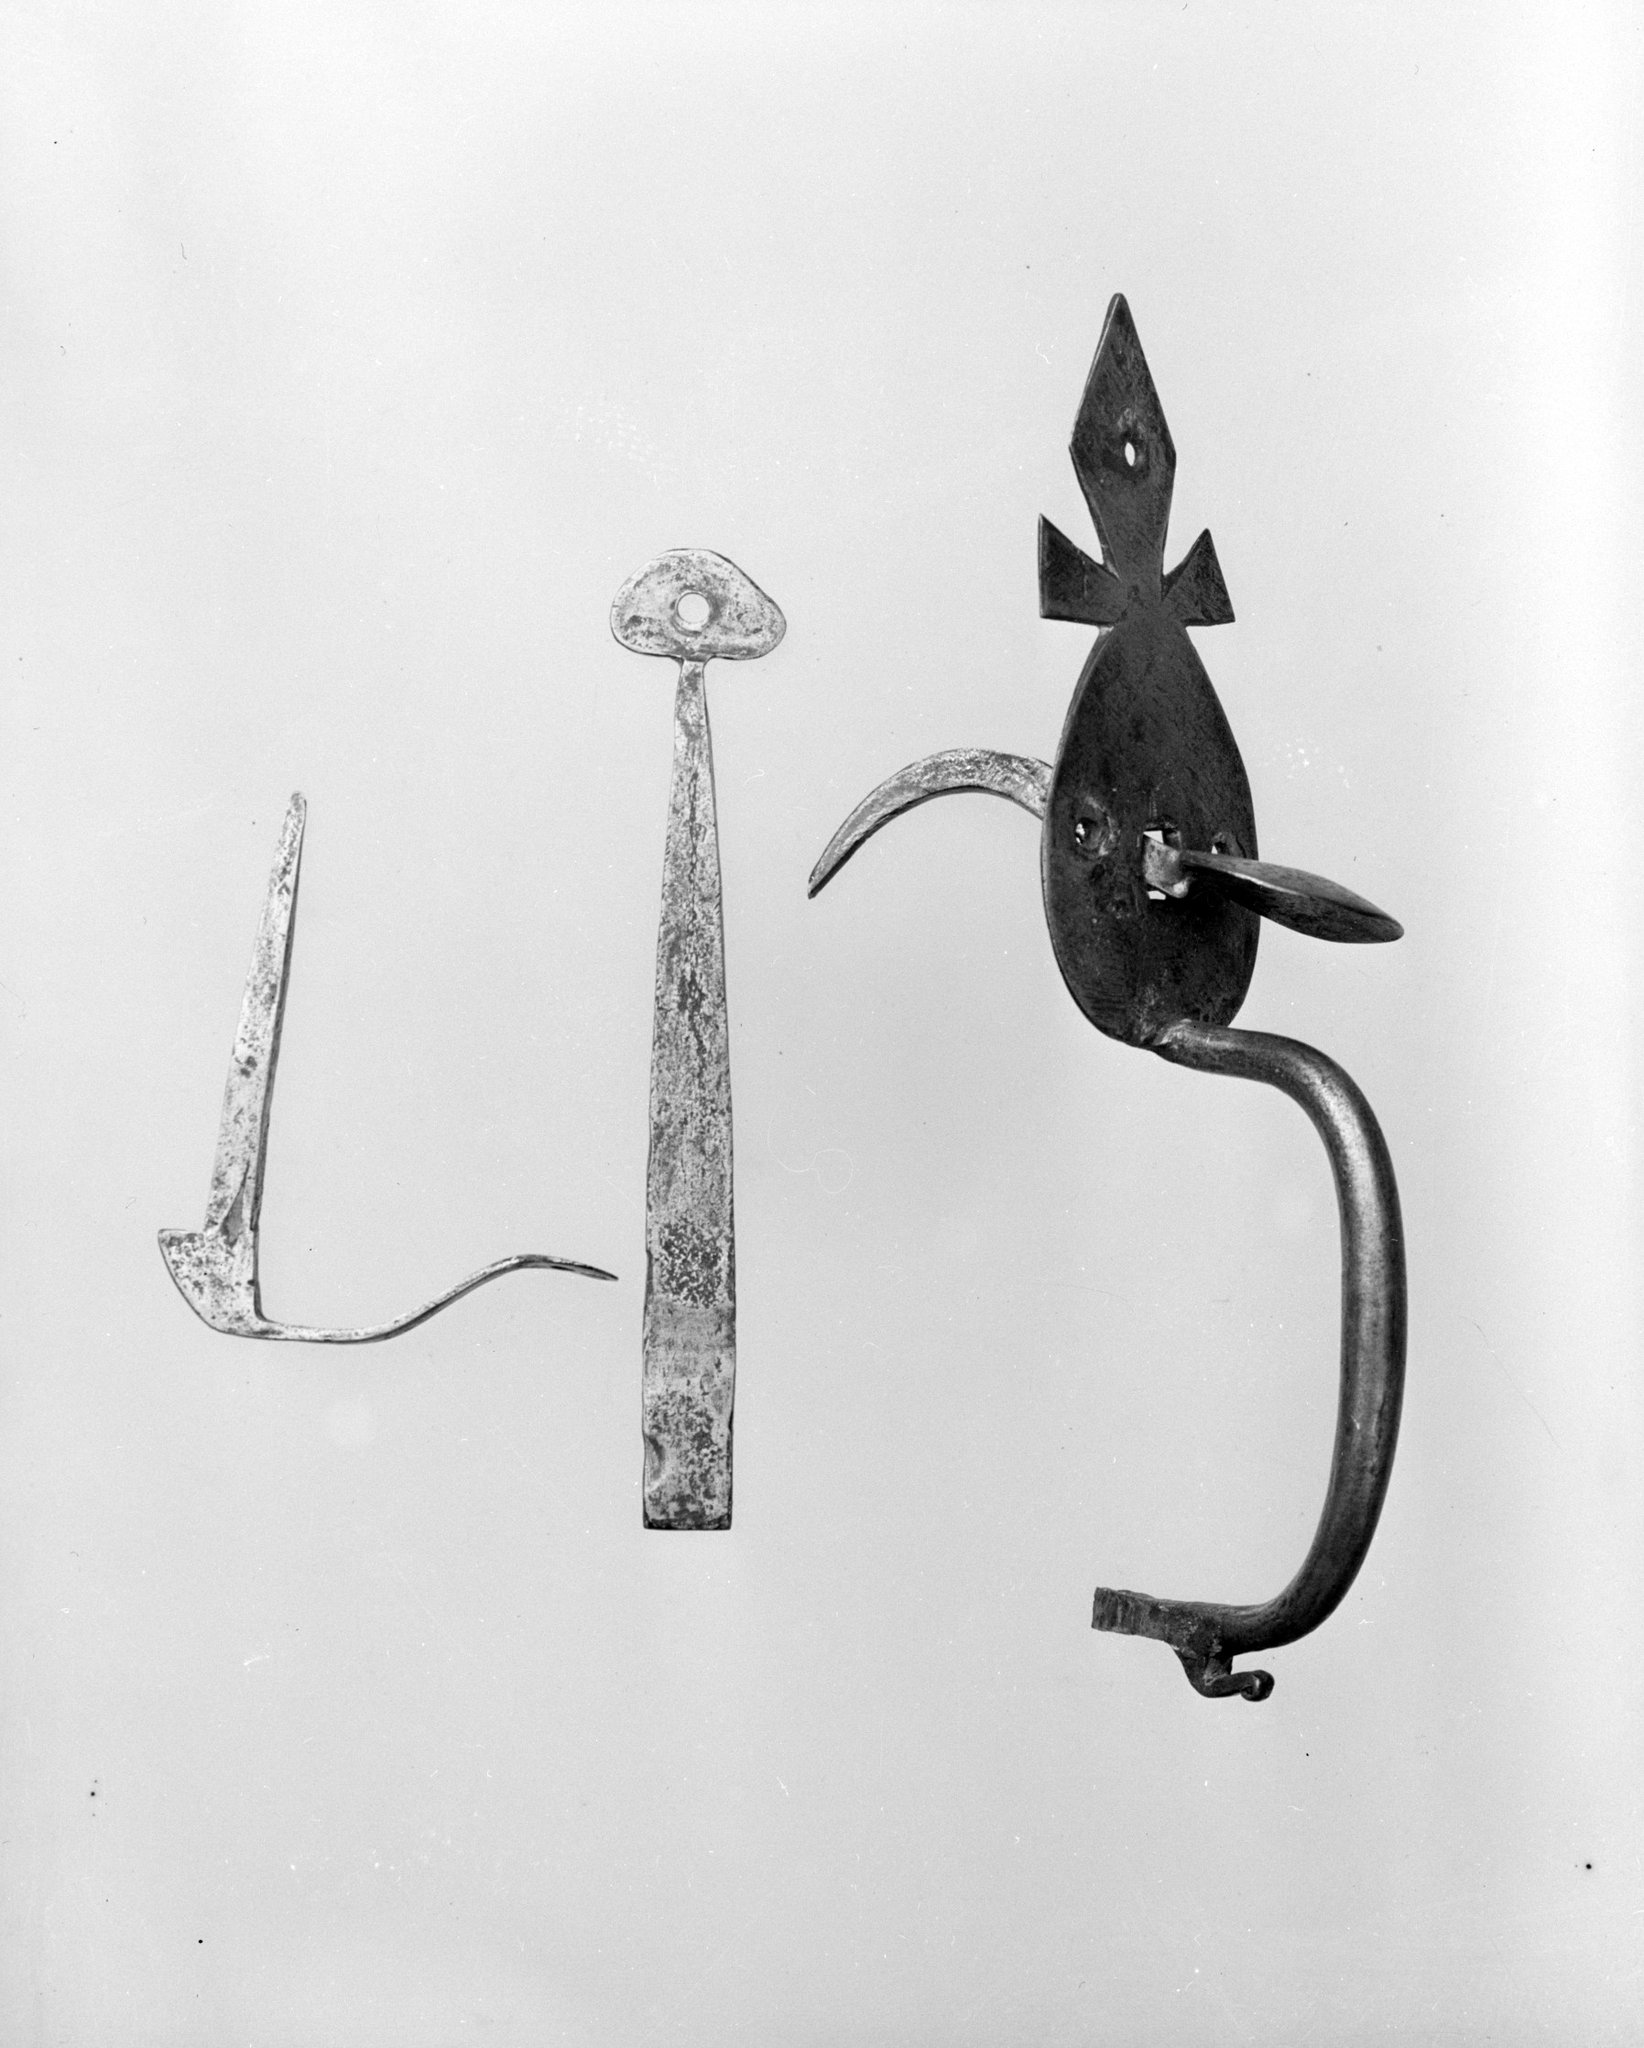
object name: latch, bar, and catch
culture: american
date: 1700-1800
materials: iron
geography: united states